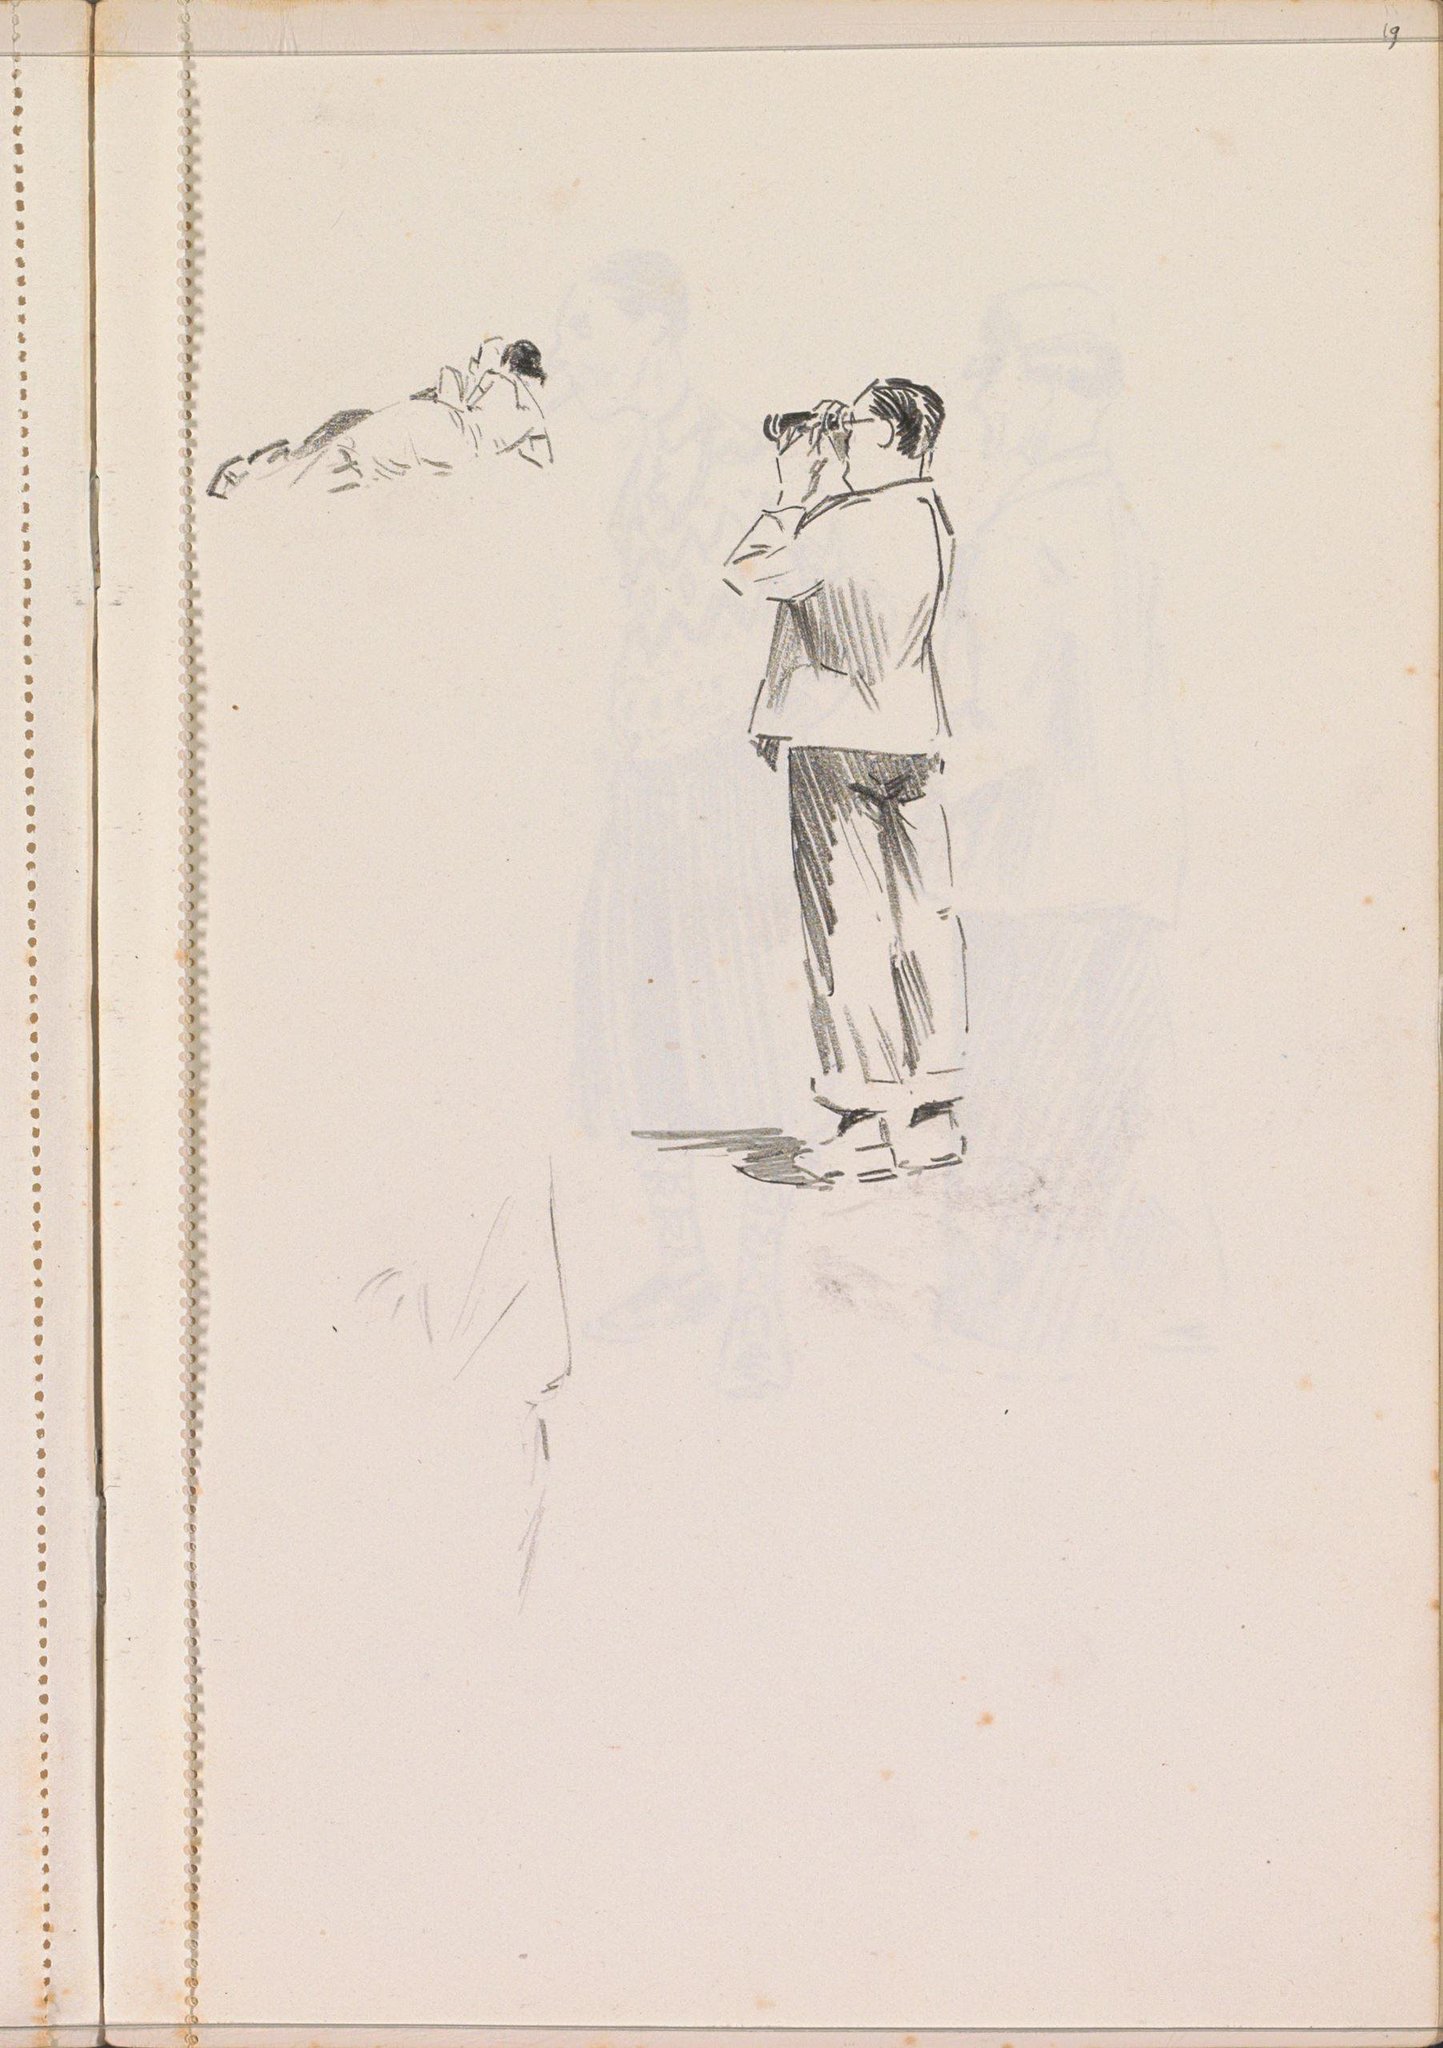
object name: sketchbook leaf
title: Man met een verrekijker en een liggende vrouw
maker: otto verhagen (i)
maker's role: draughtsman, print maker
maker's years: 1885-1951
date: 1928-1930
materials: chalk, paper, pencil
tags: lying figure, binoculars, spy-glass, etc.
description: Pagina 19 uit een schetsboek met 51 bladen.